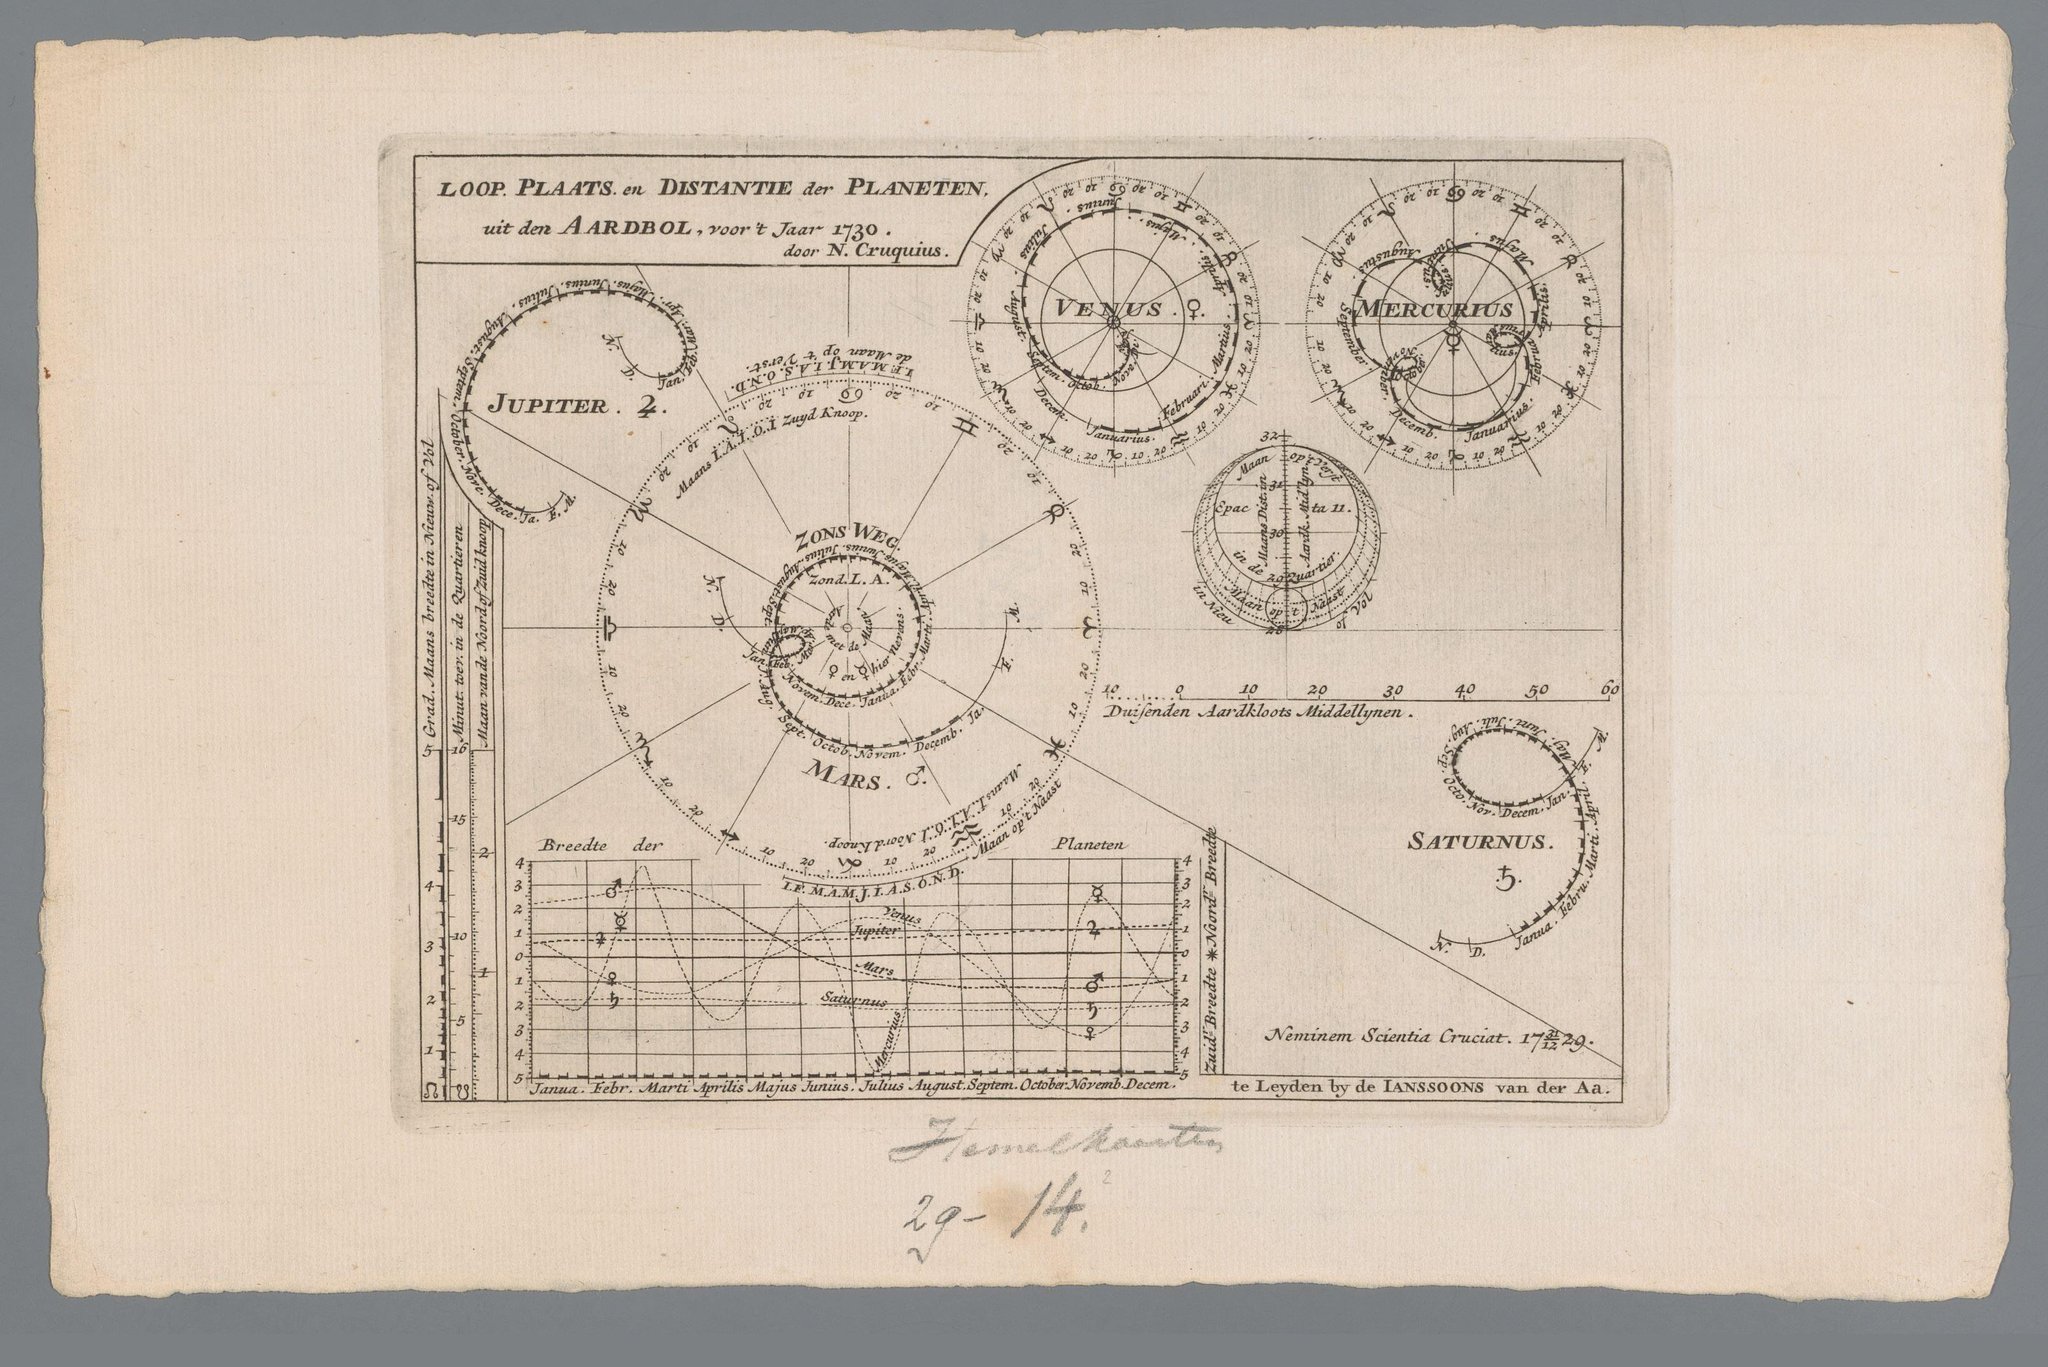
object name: print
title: Loop, plaats en distantie der planeten, uit den aardbol voor 't jaar 1730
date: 1729-1730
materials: paper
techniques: engraving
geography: leiden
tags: star-chart, star map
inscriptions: date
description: Kaart met de planetenbanen voor het jaar 1730. Onder een tabel met de stand van de planeten per maand. In het midden kaarten met de baan van de planeten.